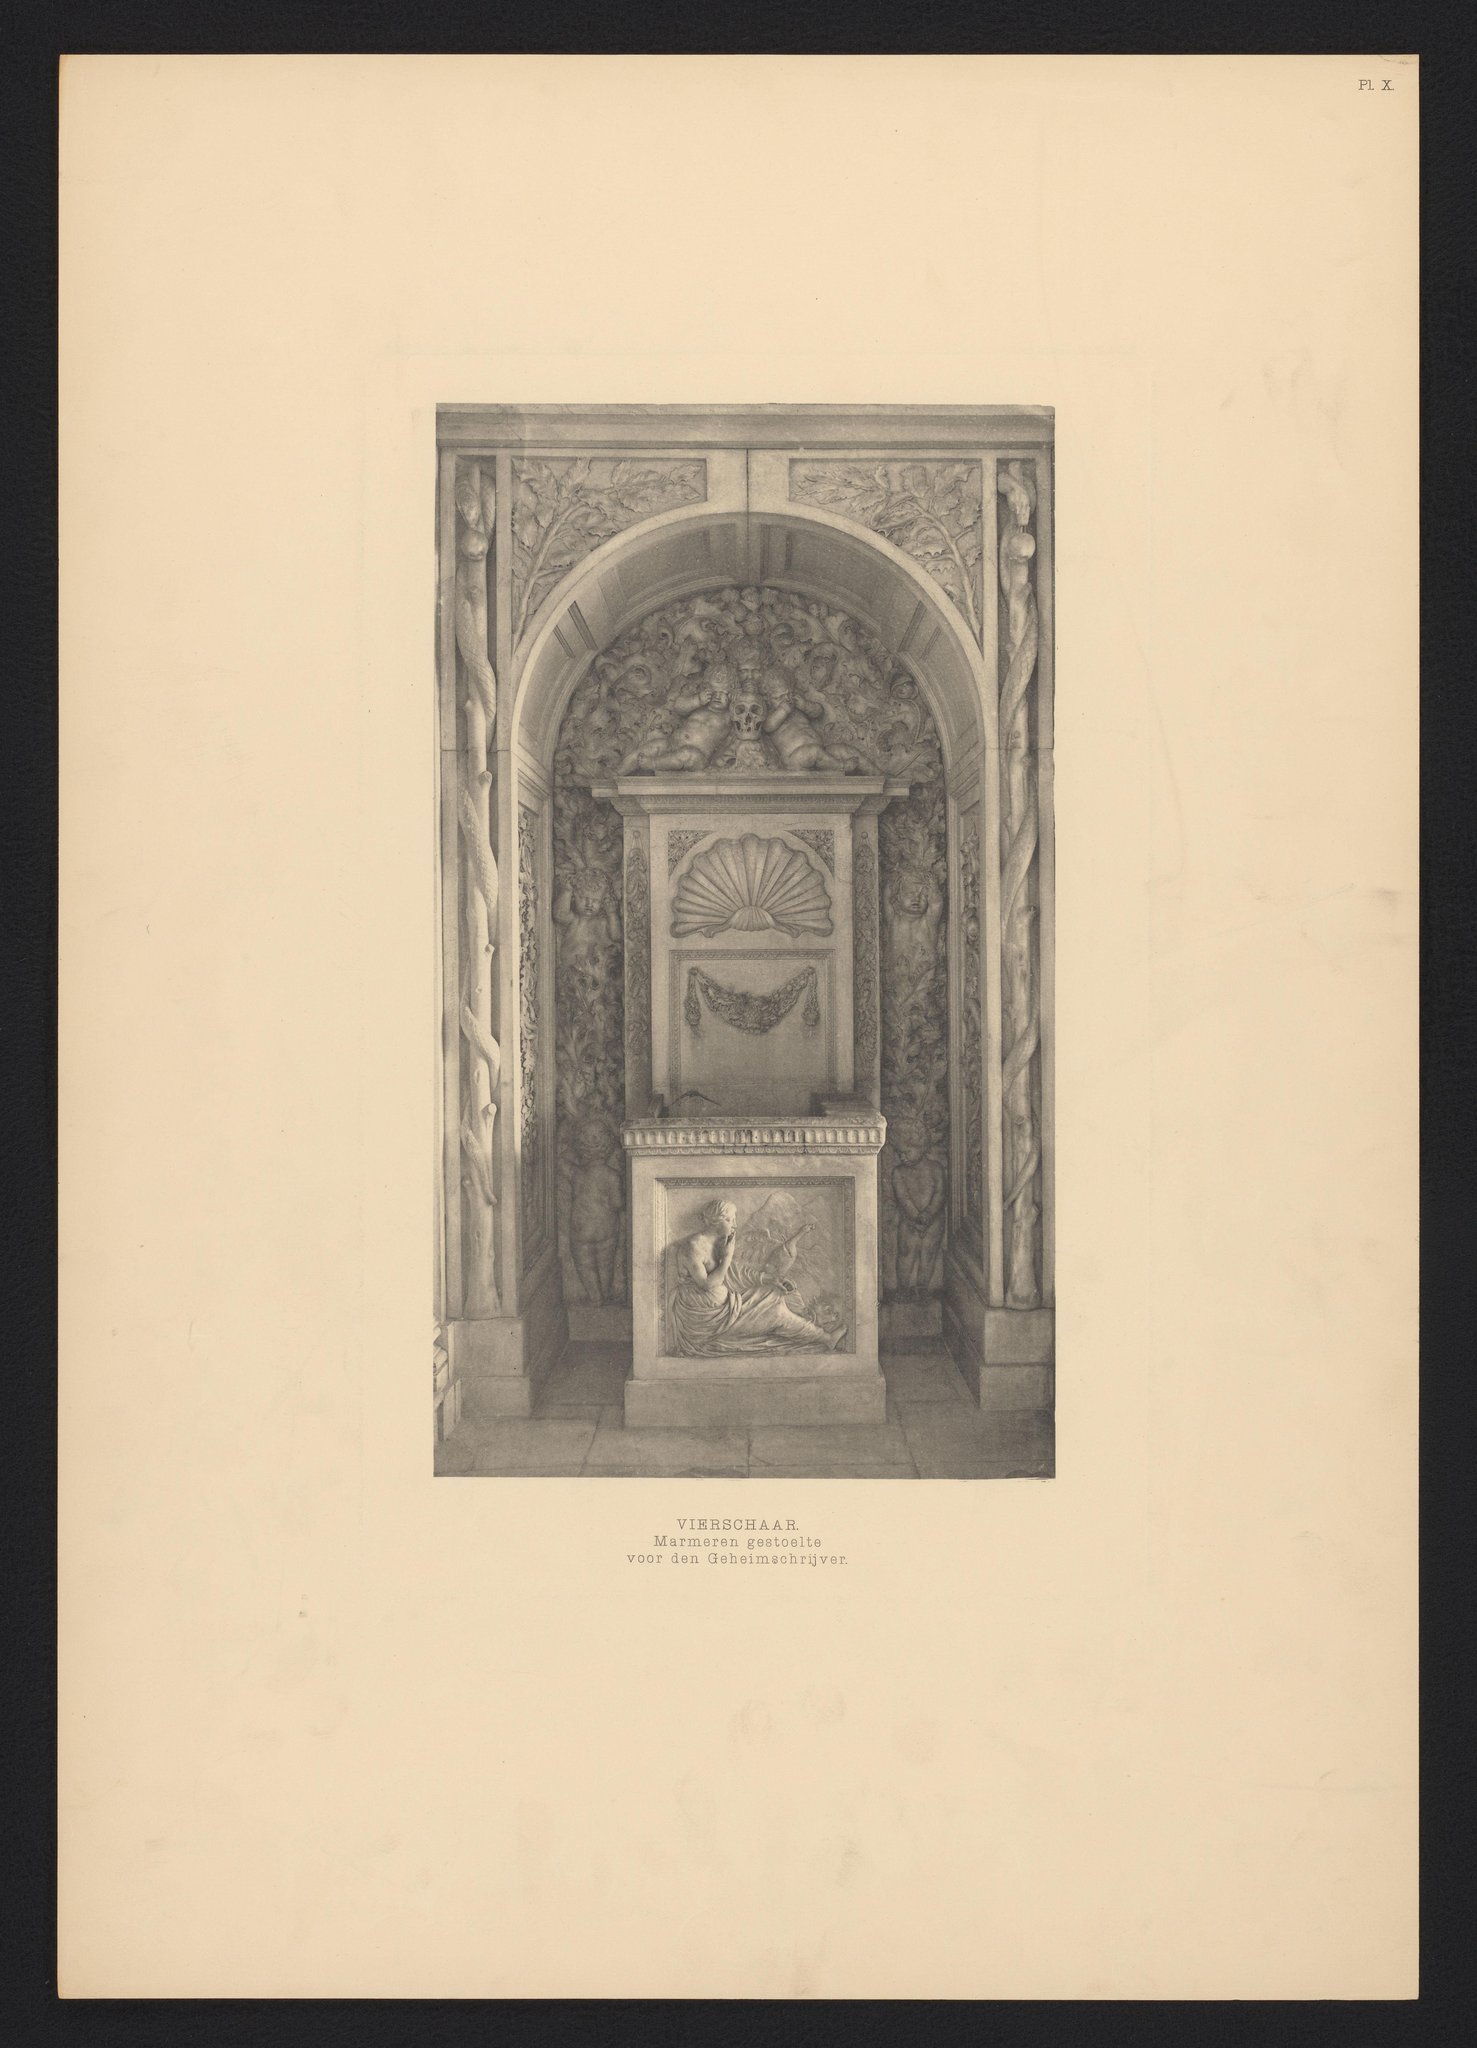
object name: photograph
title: C.T.J. Louis Rieber, Het Koninklijk Paleis te Amsterdam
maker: Anonymous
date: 1899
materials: cardboard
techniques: photograph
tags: seating furniture, palace, royal palace of amsterdam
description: Vierschaar. Marmeren gestoelte voor den Geheimschrijver.